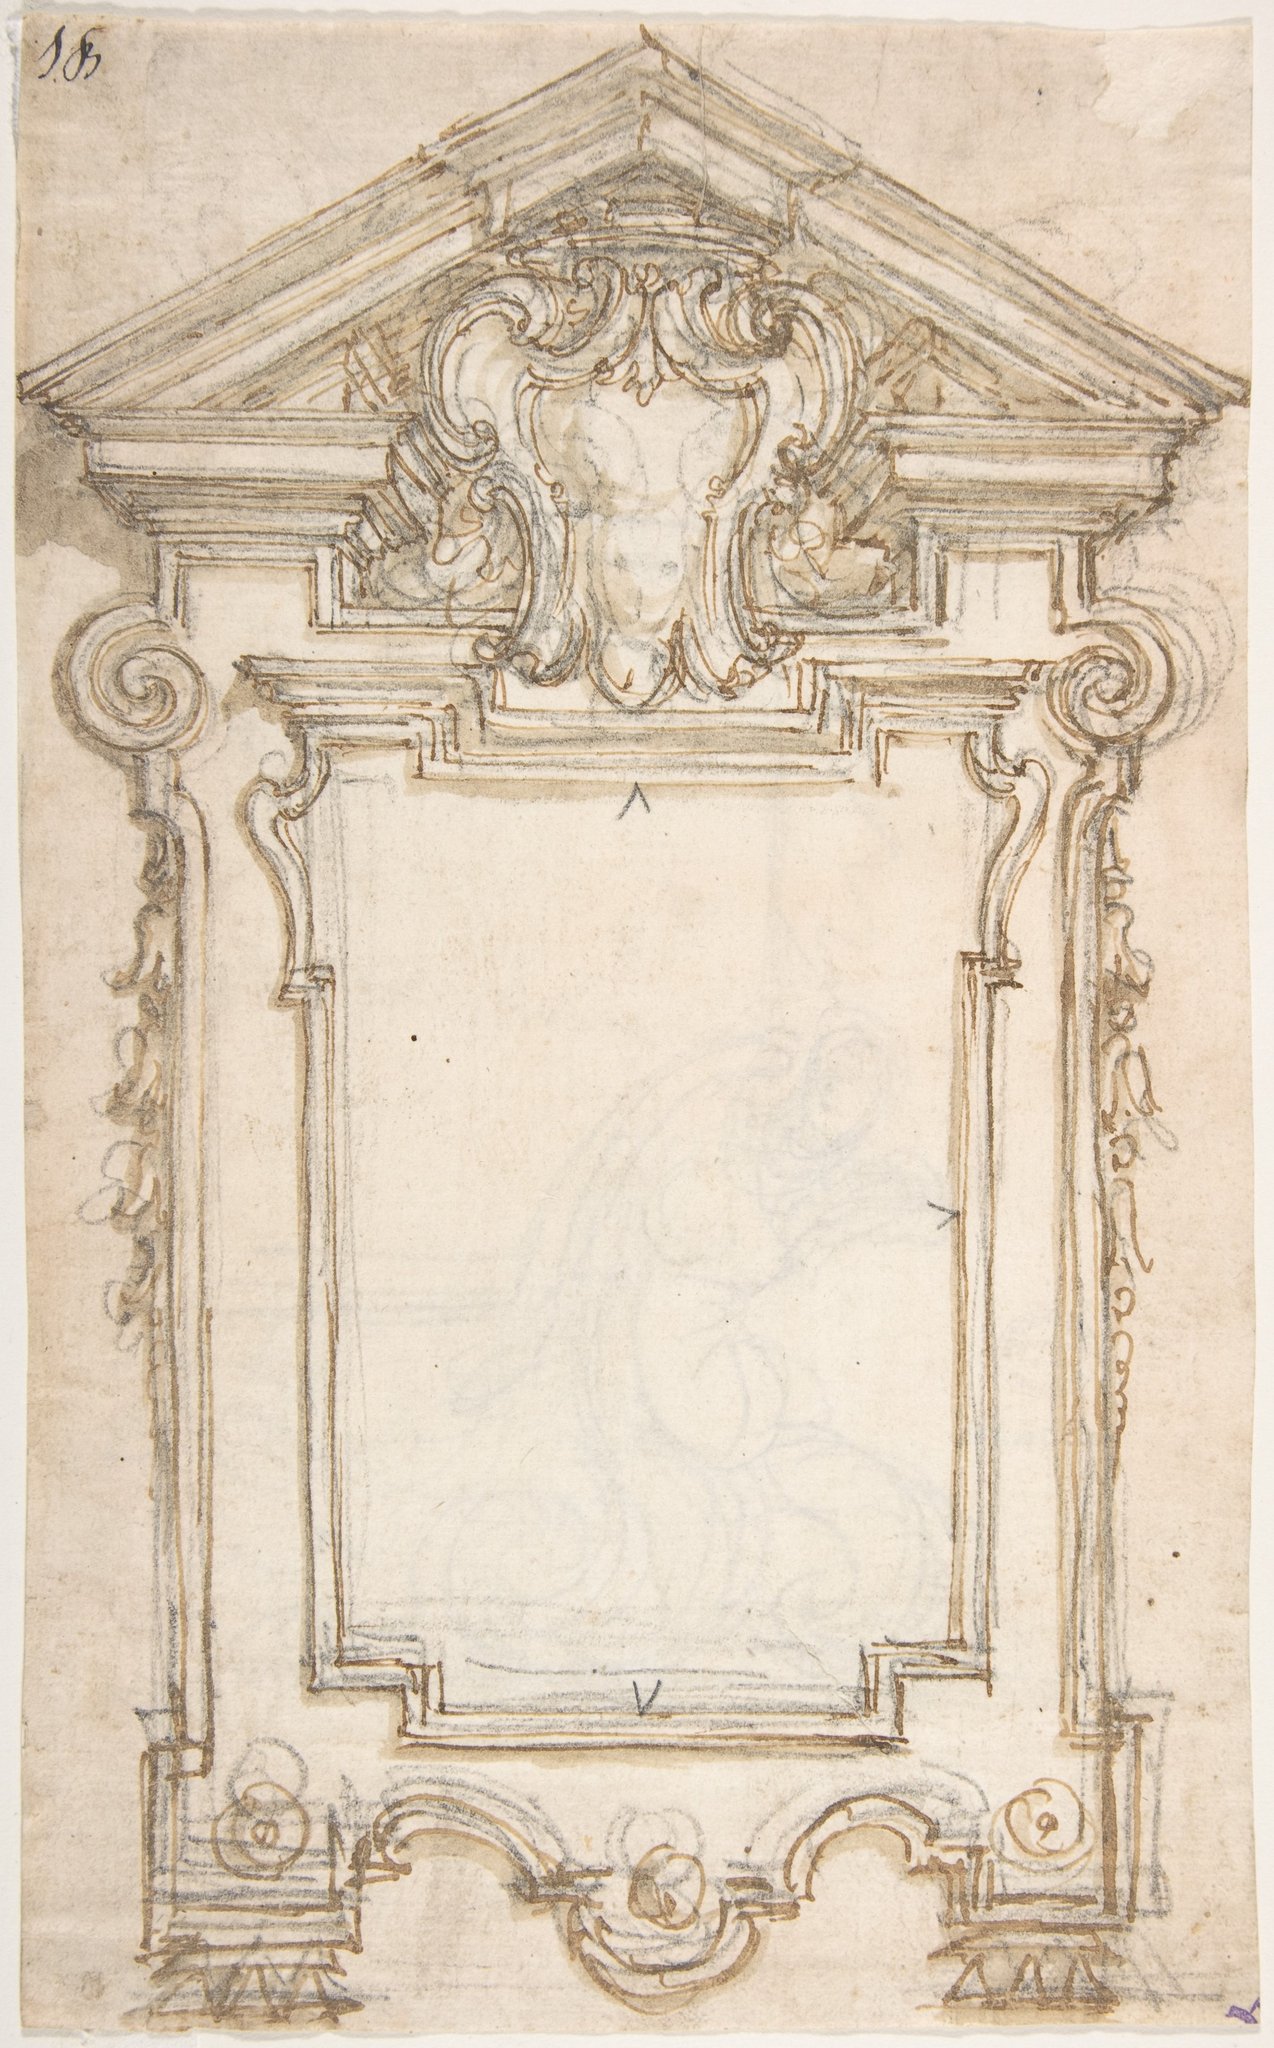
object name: drawing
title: Design for a Frame or Epitaph (recto); Caryatid Supporting a Frame (verso)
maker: giovanni battista foggini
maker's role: artist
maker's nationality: italian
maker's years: 1652-1725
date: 1672-1725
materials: chalk, ink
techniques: brush, pen, wash